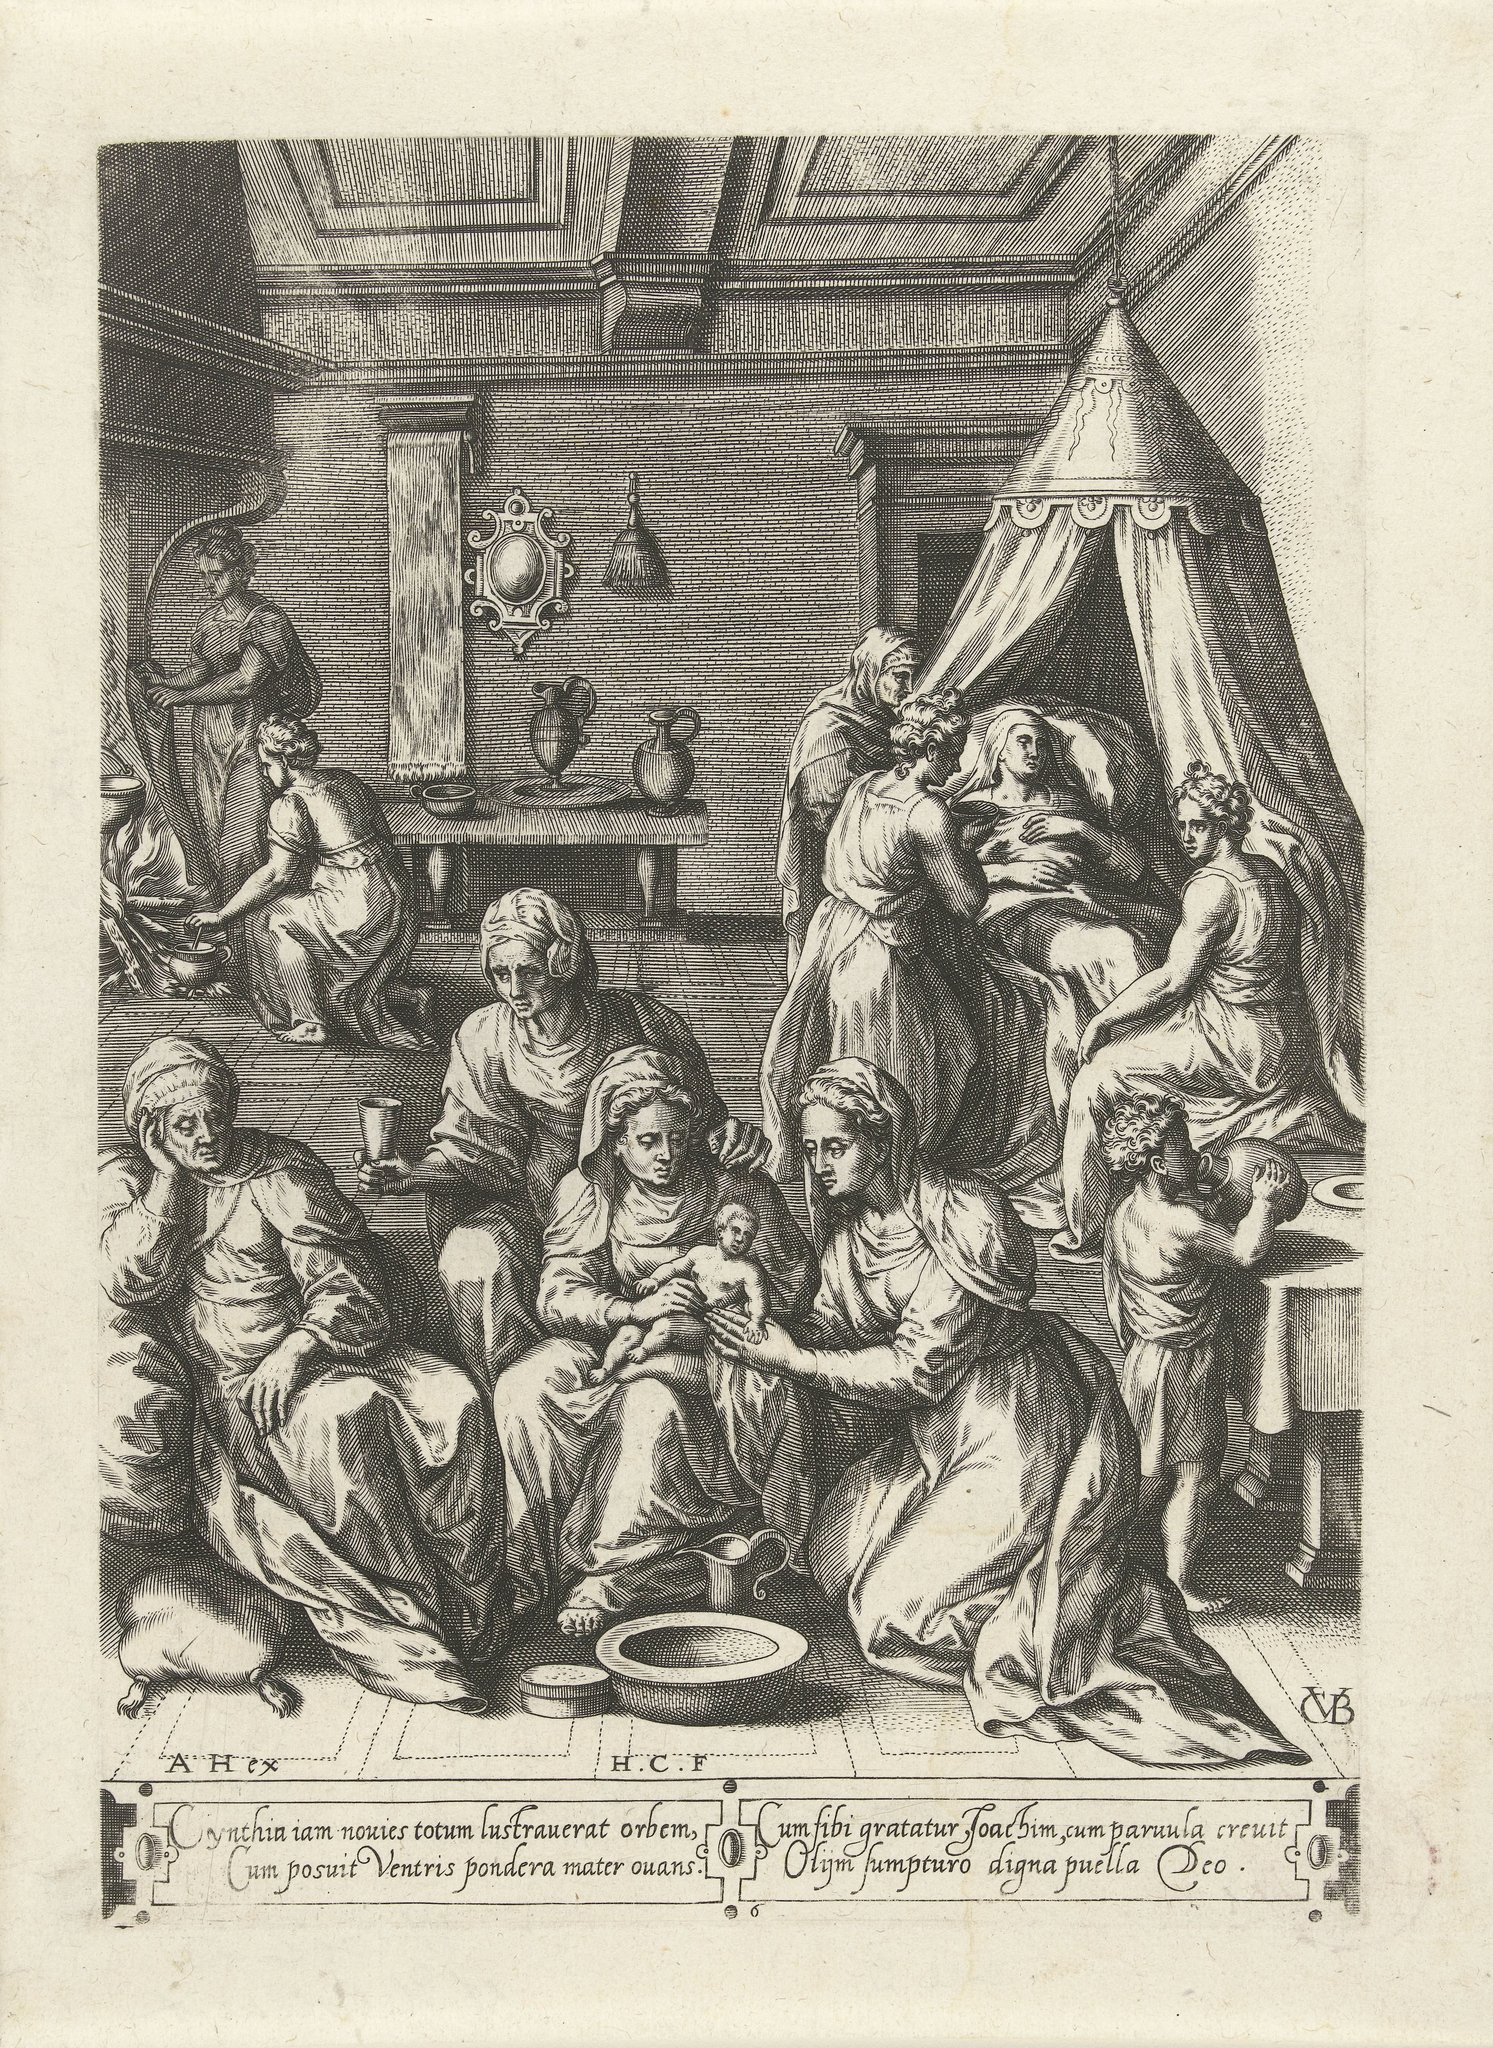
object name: print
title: Geboorte van Maria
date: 1576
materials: paper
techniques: engraving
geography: antwerp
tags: birth of mary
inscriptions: collector's mark: Lugt 240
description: De Heilige Anna zit op de grond. Een vroedvrouw biedt haar een beker aan om uit te drinken. Naast haar verzorgen twee andere vroedvrouwen de pasgeboren Maria. Op de achtergrond de Heilige Anna in bed. De prent heeft een Latijns onderschrift en maakt deel uit van een serie over het leven van Maria.